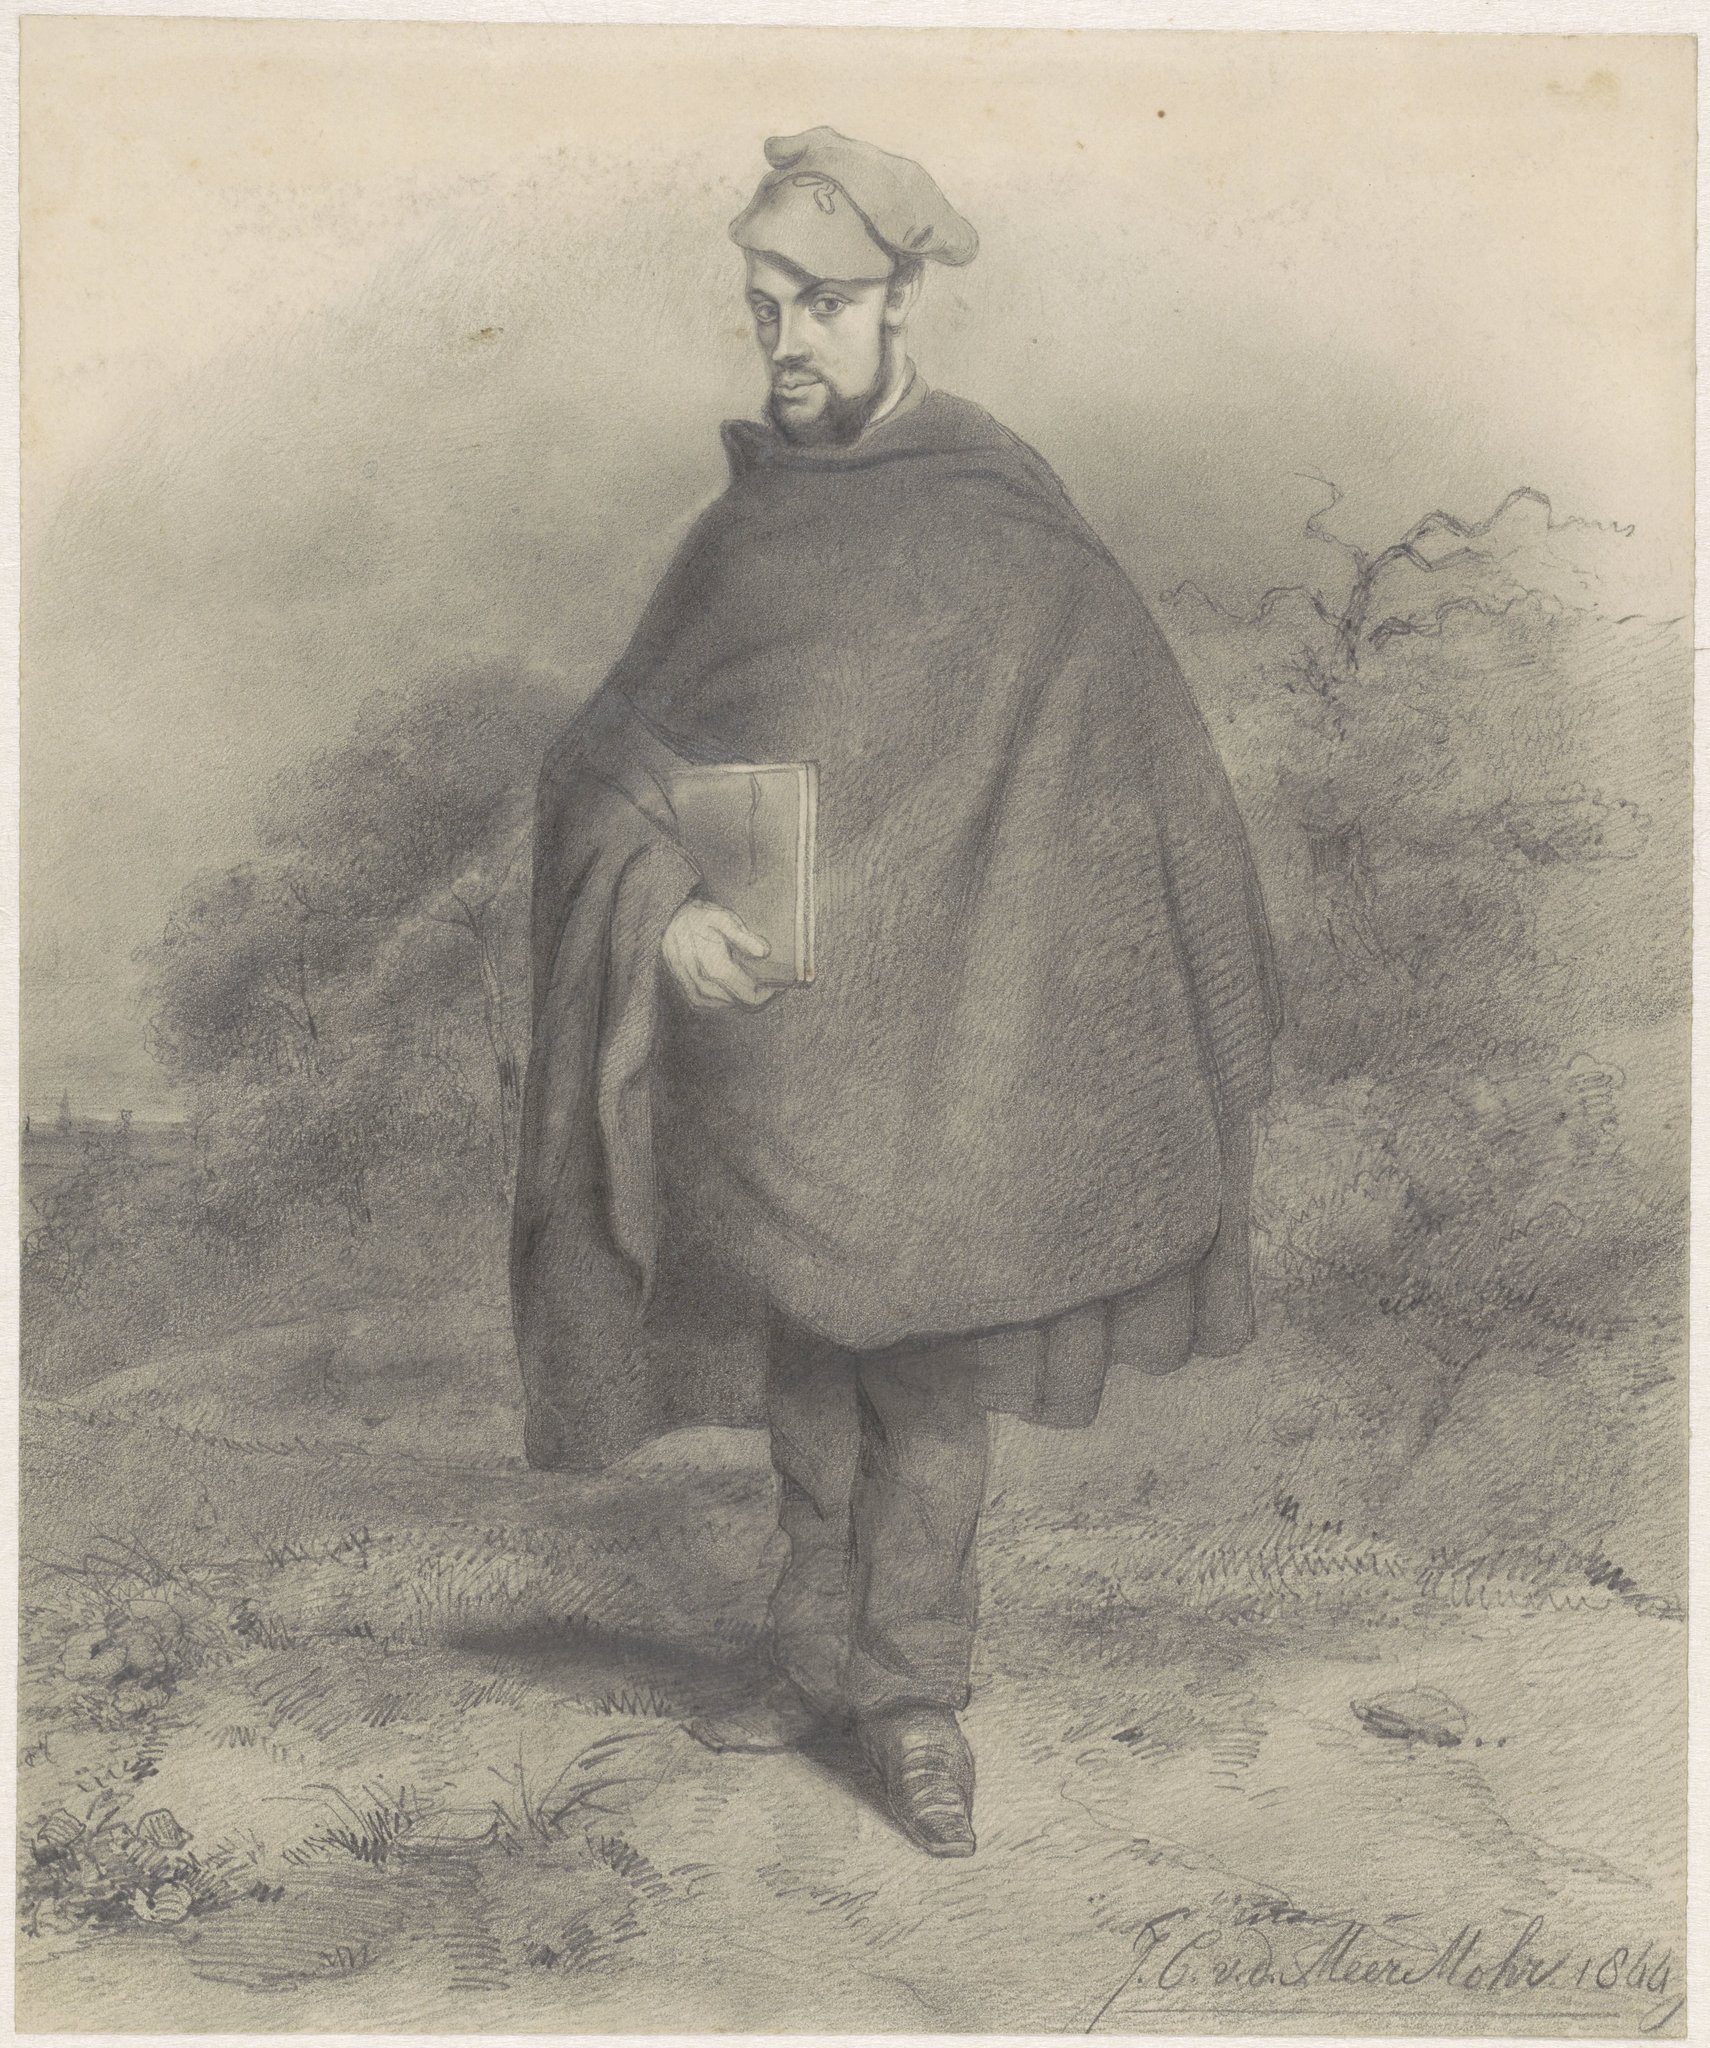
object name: drawing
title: Portret van Theodorus Hentzepeter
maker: johannes carolus van der meer mohr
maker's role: draughtsman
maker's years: 1821-1876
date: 1866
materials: paper, pencil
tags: painter, historical persons, portrait, self-portrait of painter, portrait, self-portrait of artist, portrait, self-portrait of draughtsman